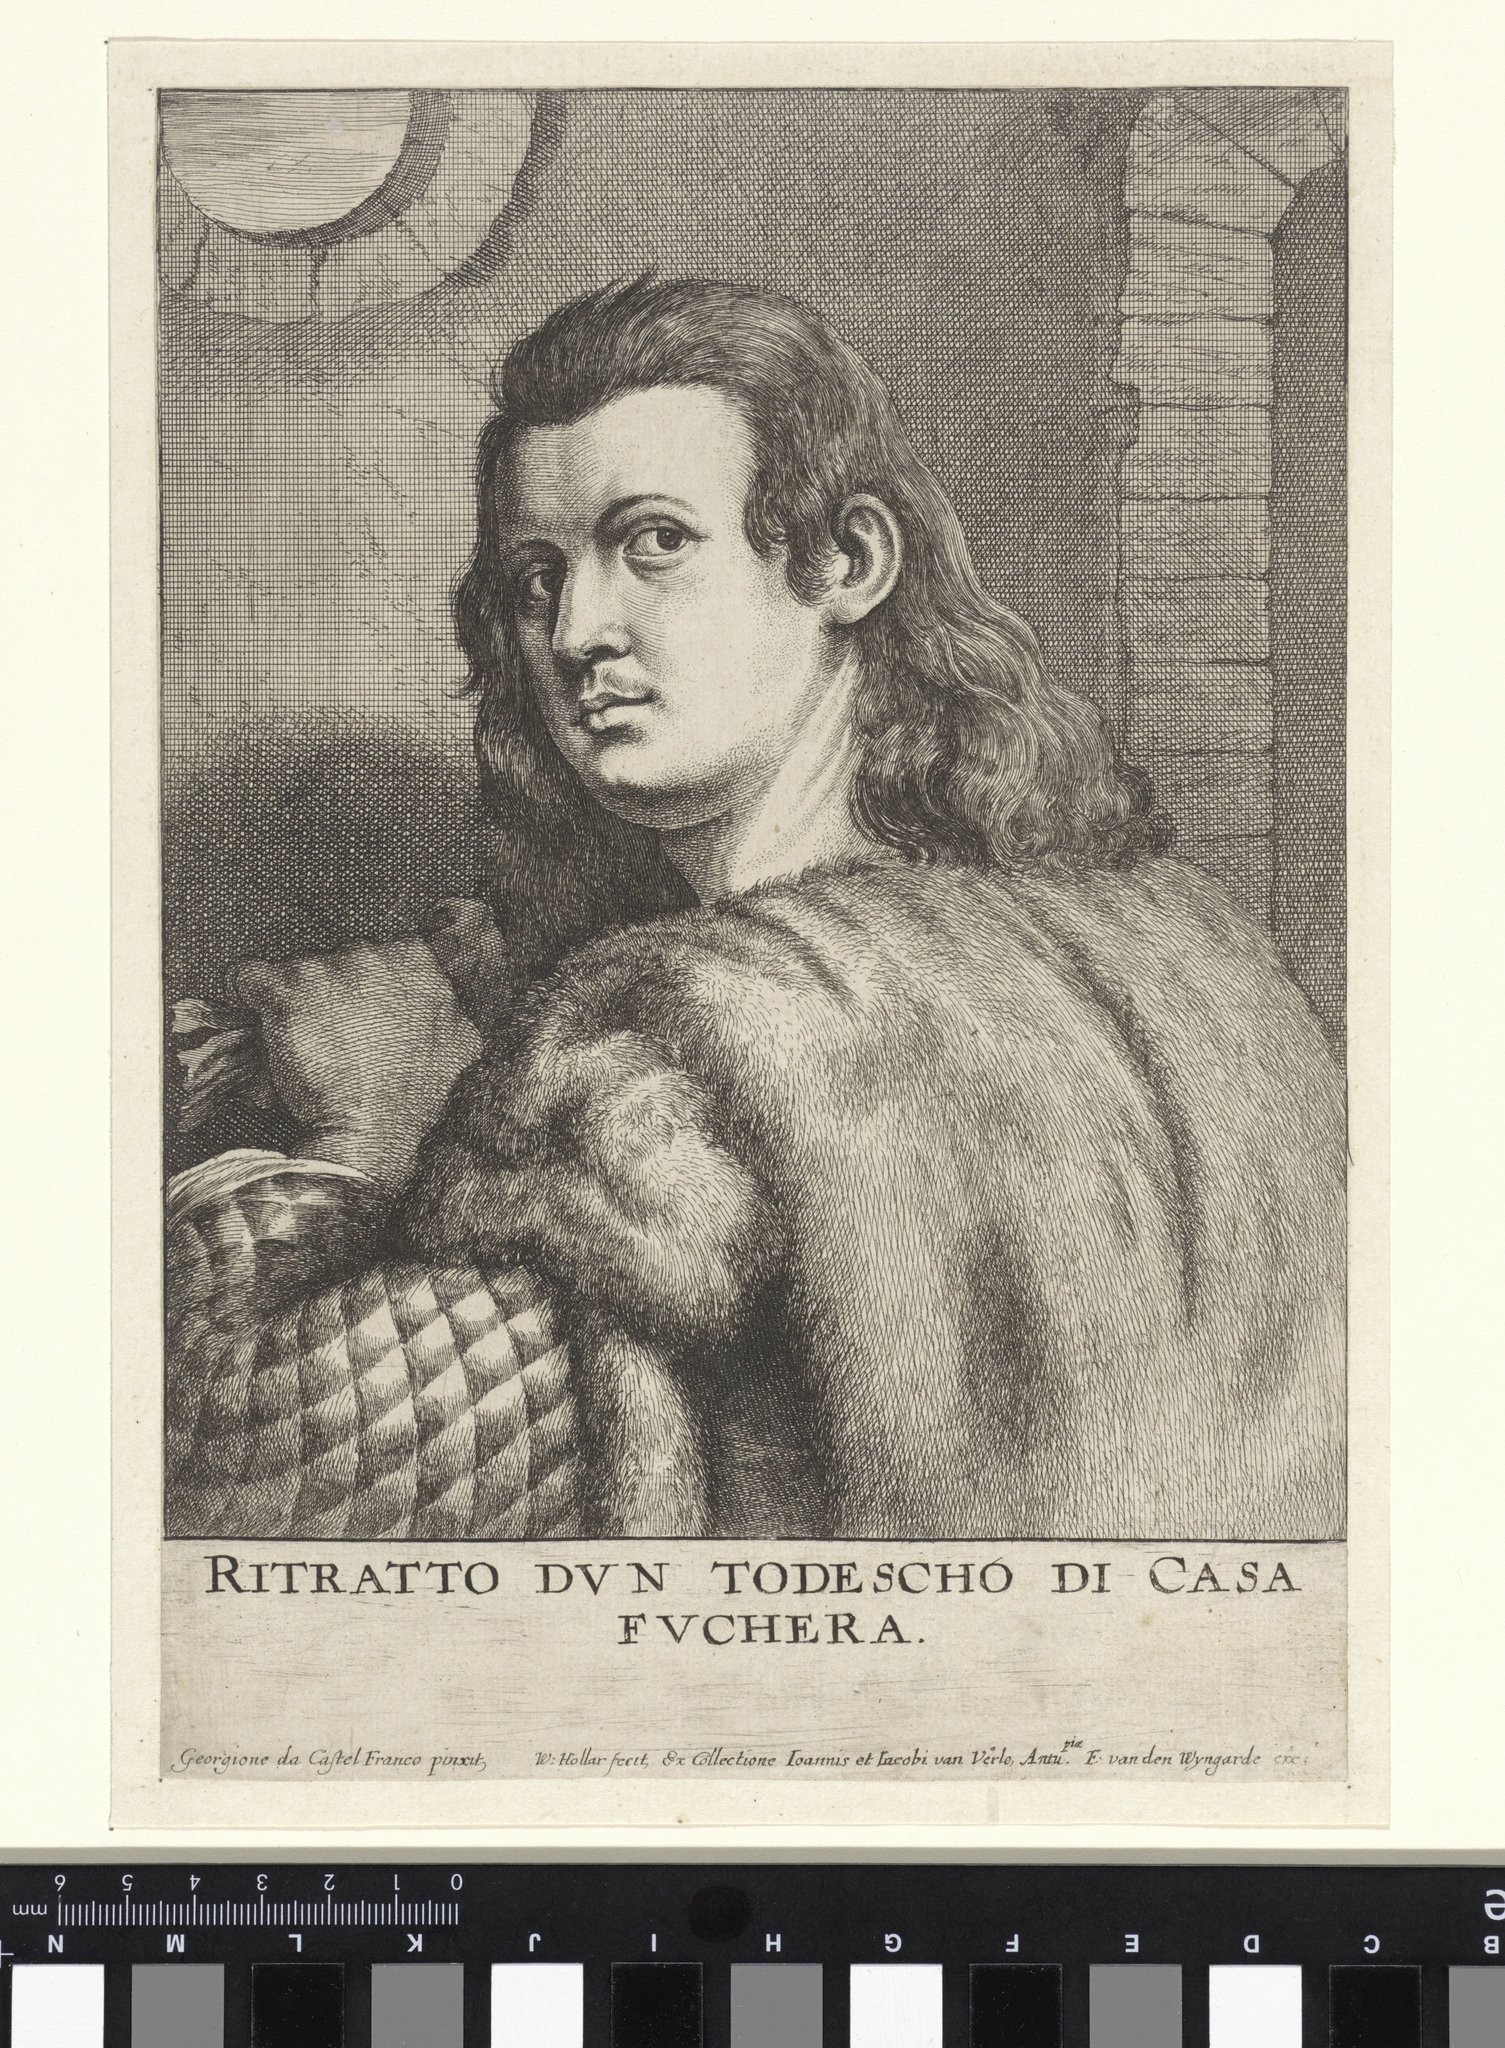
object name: print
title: Italiaanse portretten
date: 1649-1651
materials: paper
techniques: etching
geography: antwerp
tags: painter, buonamico buffalmacco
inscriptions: collector's mark: Lugt 240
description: De prent maakt deel uit van een tiendelige serie met Italiaanse portretten (ongenummerd).